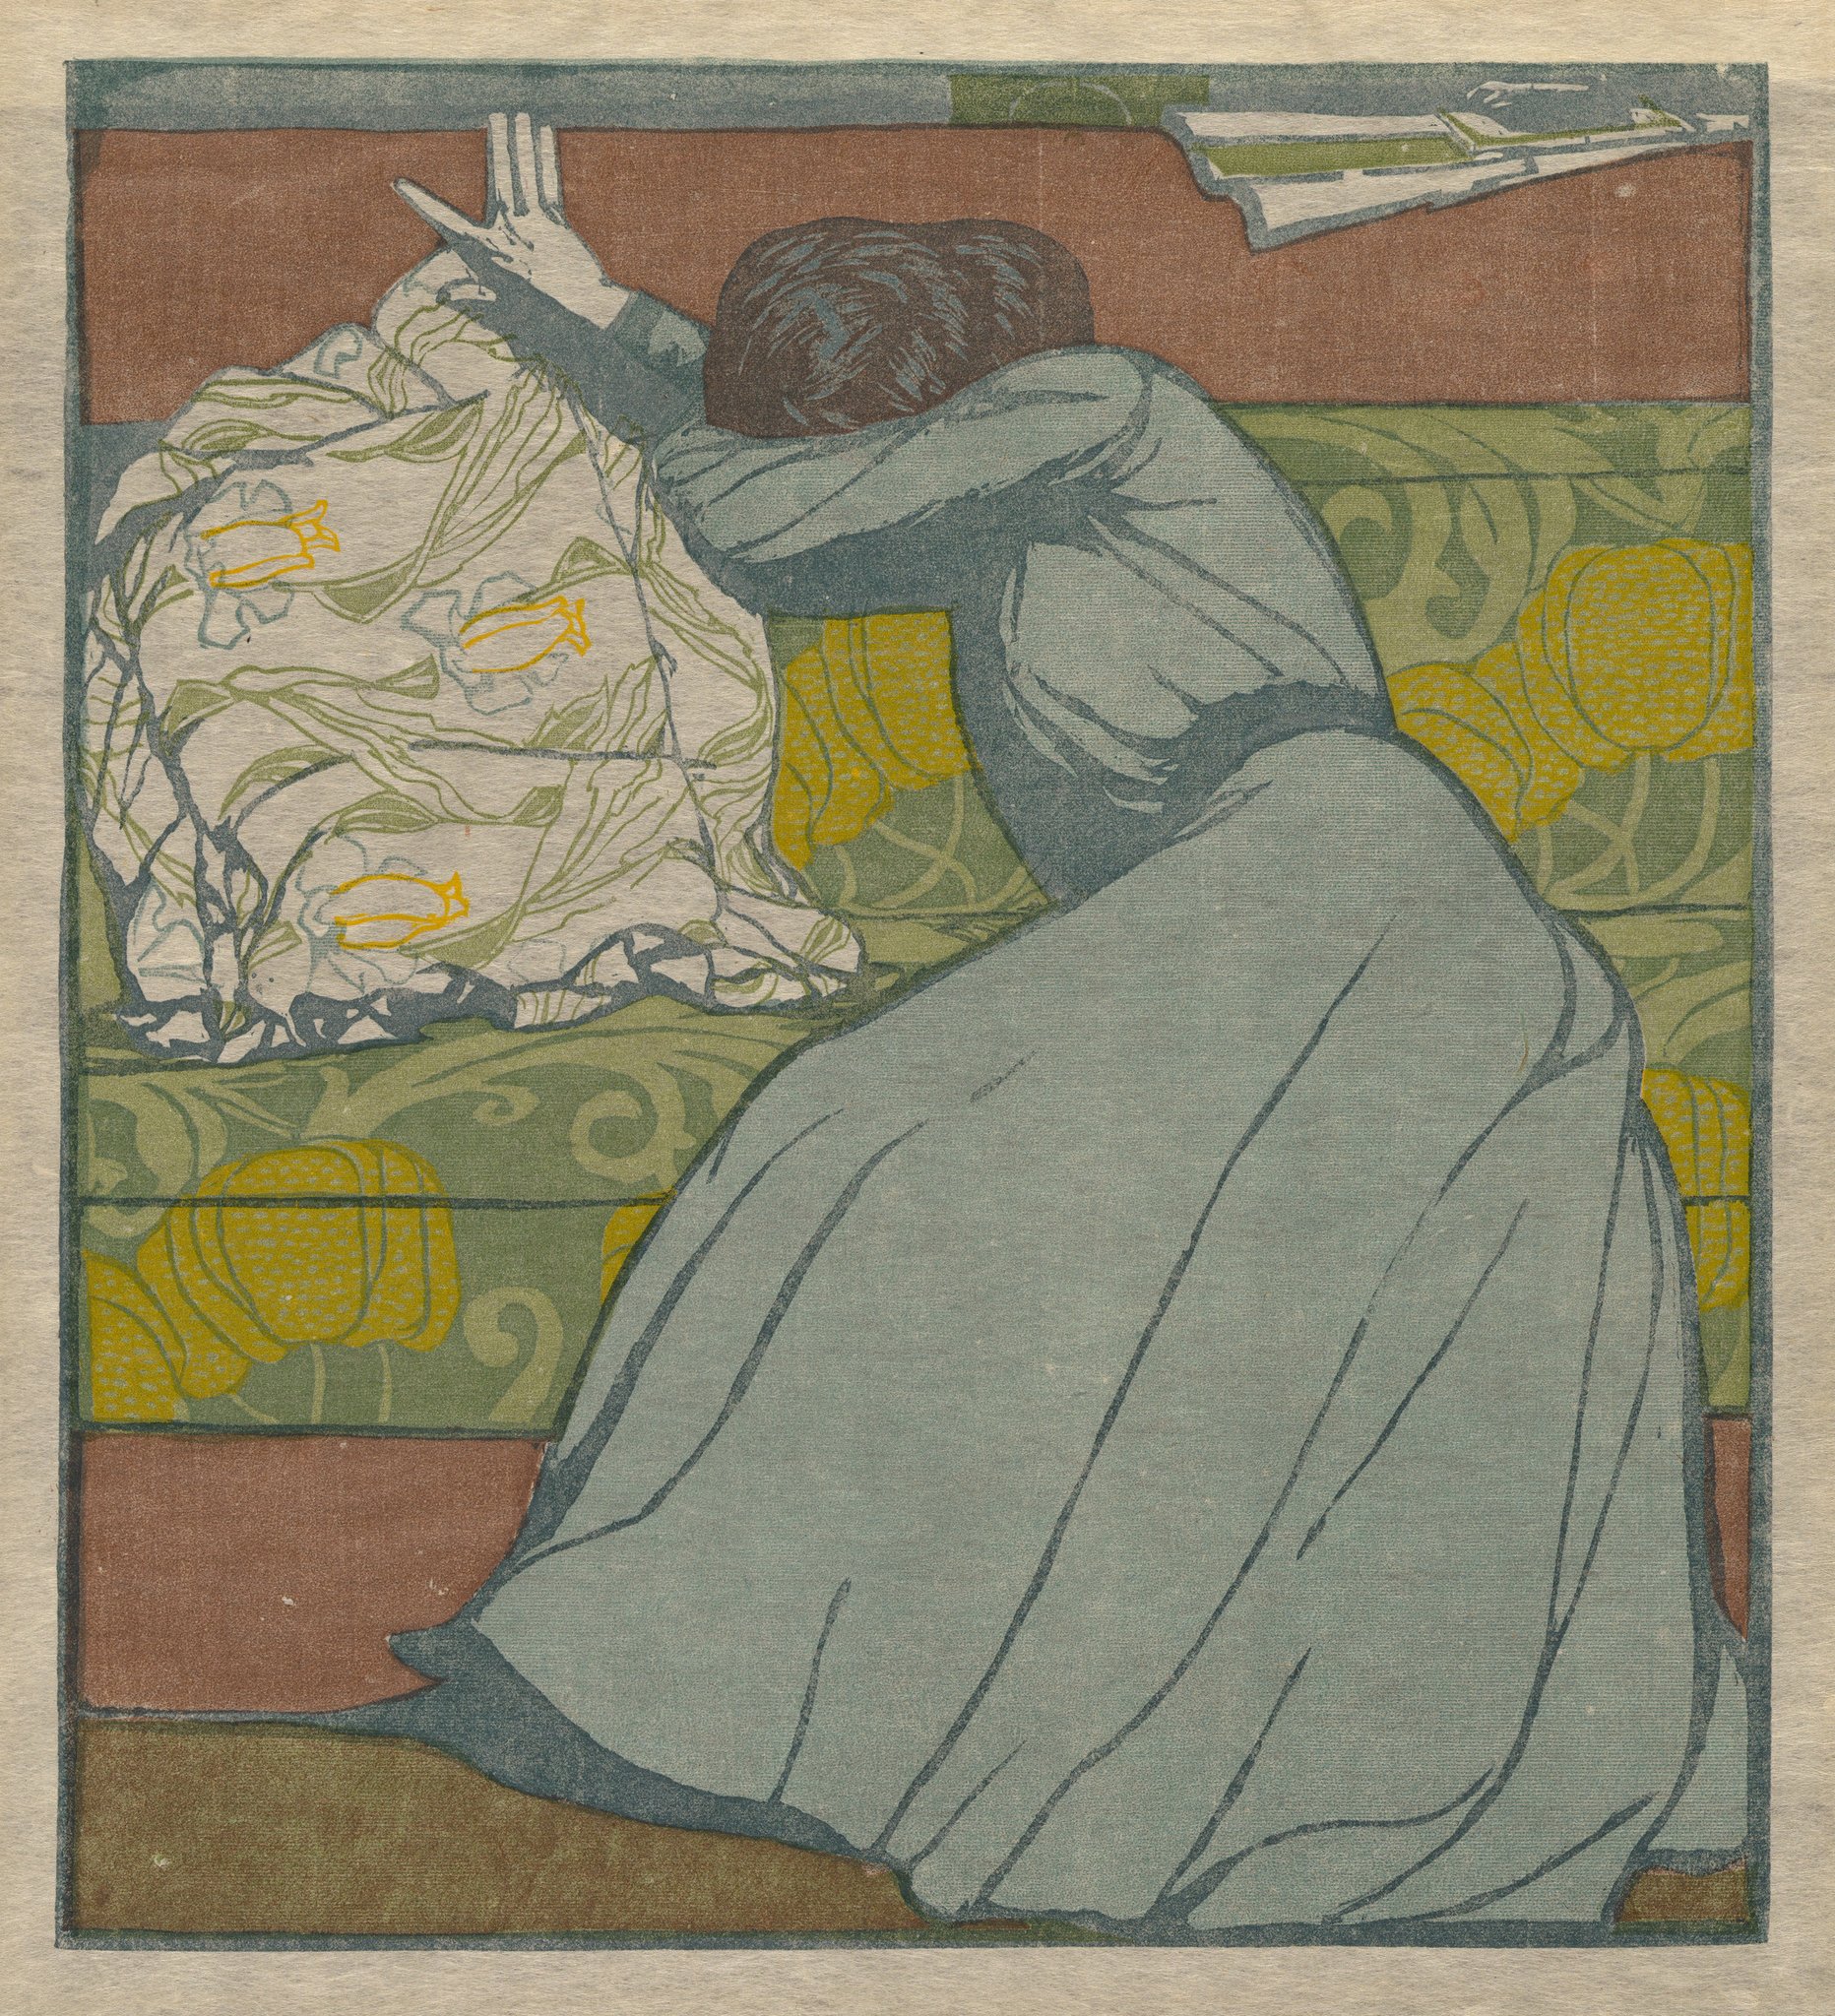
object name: poster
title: Cushion (Martha Kurzweil Seated on a Divan)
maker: max kurzweil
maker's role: artist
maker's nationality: austrian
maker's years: 1867-1916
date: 1900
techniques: woodcut